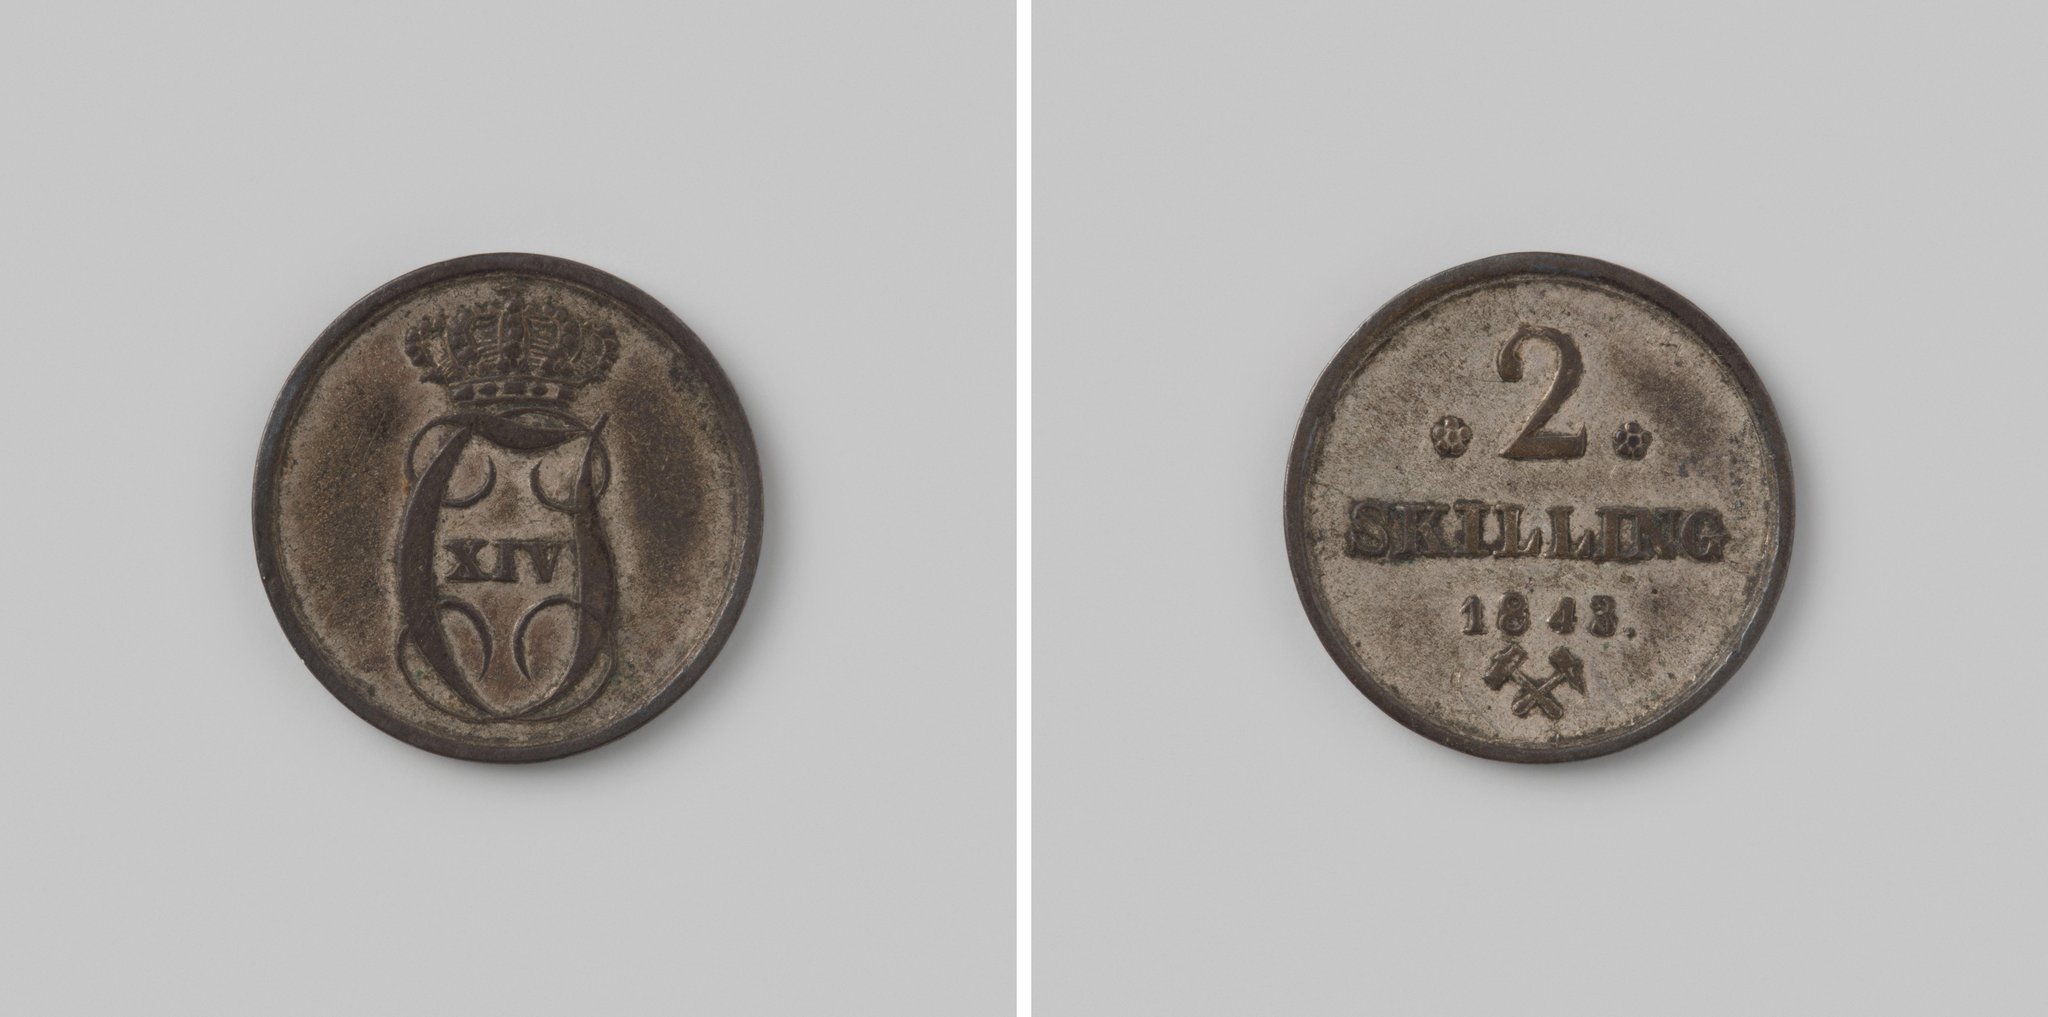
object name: coin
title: Noorwegen, Karel XIV Johan, 2 skilling, 1843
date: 1843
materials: silver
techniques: striking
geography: kongsberg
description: Zilveren munt. Voorzijde: gekroond monogram van de vorst. Keerzijde: waarde-aanduiding in twee regels. Daaronder jaartal, waaronder aanduiding van de muntplaats. Gladde rand.